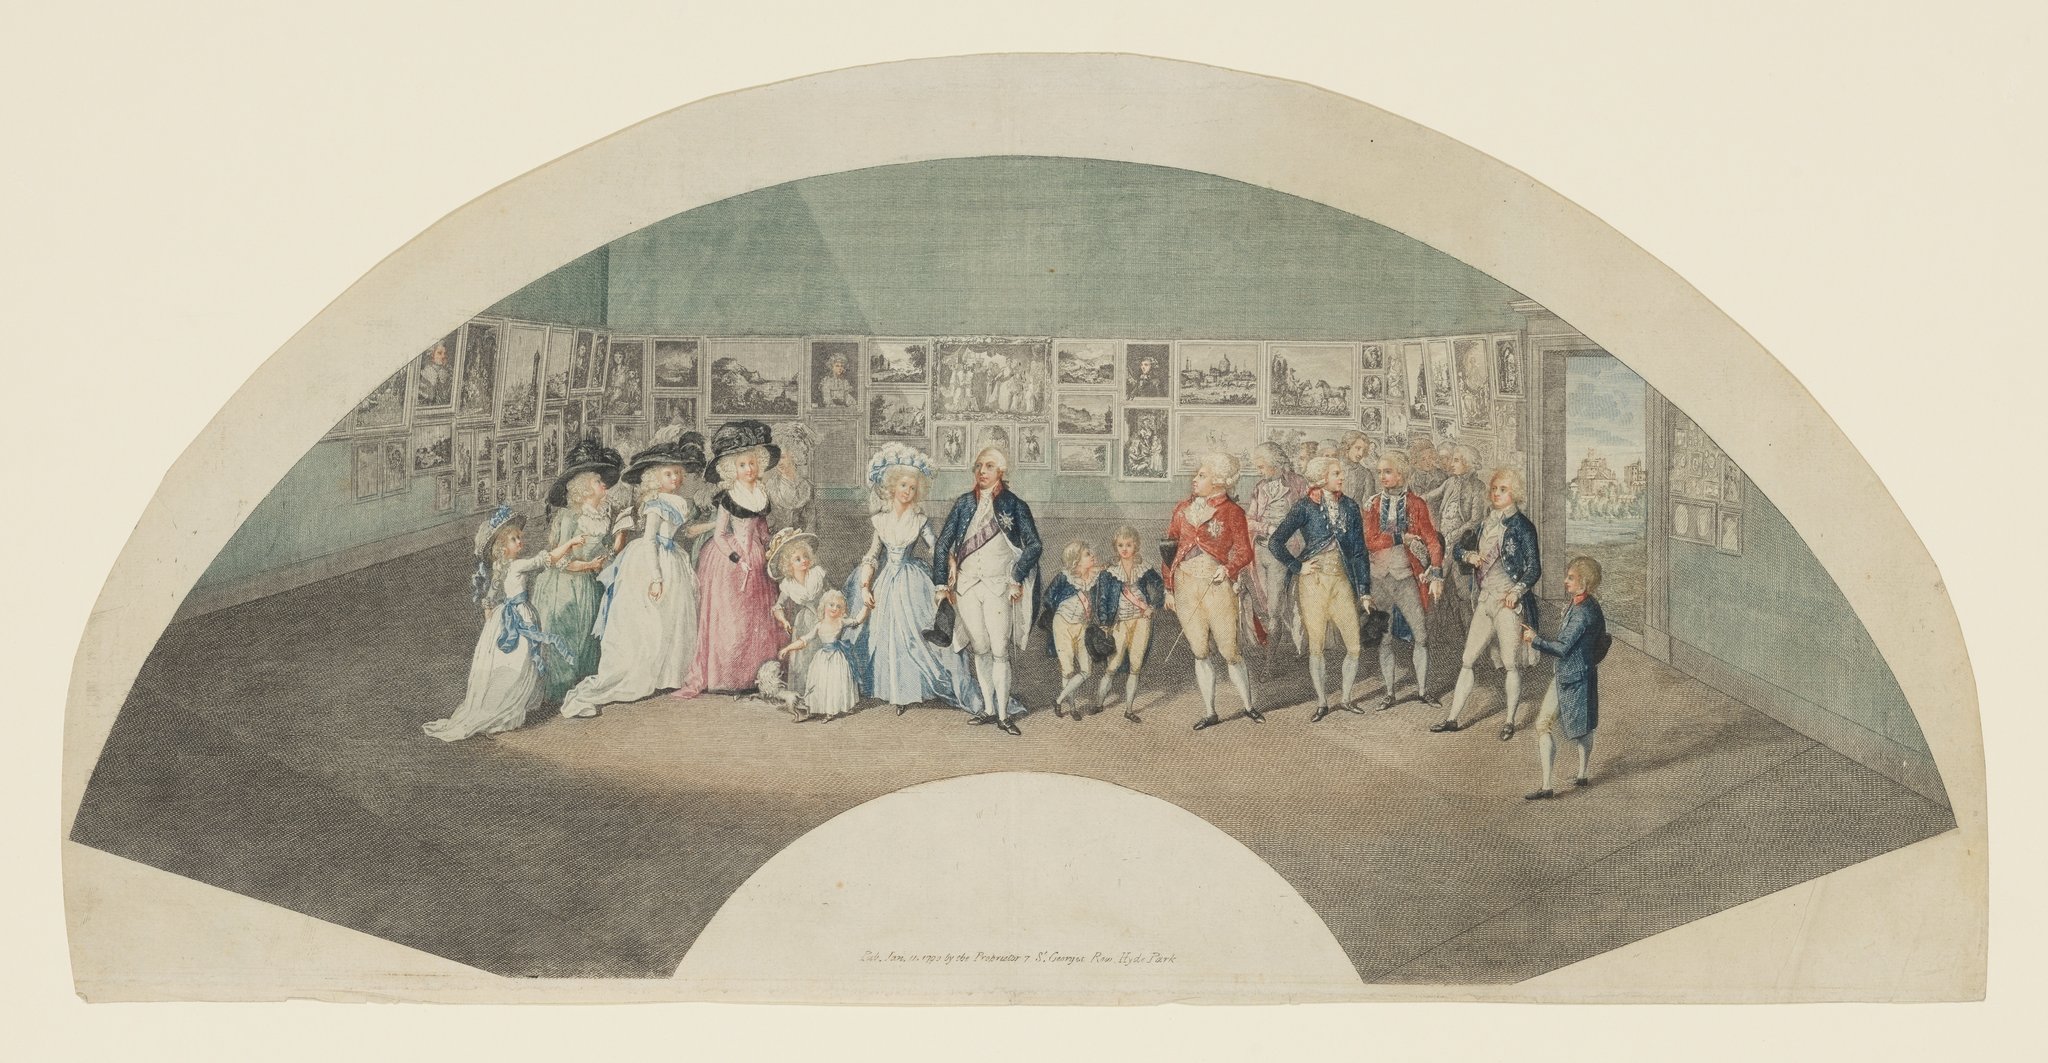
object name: print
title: George III, Queen Charlotte, the Prince of Wales and others in a Picture Gallery near Windsor Castle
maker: johann heinrich ramberg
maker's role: artist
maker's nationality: german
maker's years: 1763-1840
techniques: etching, printing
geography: england